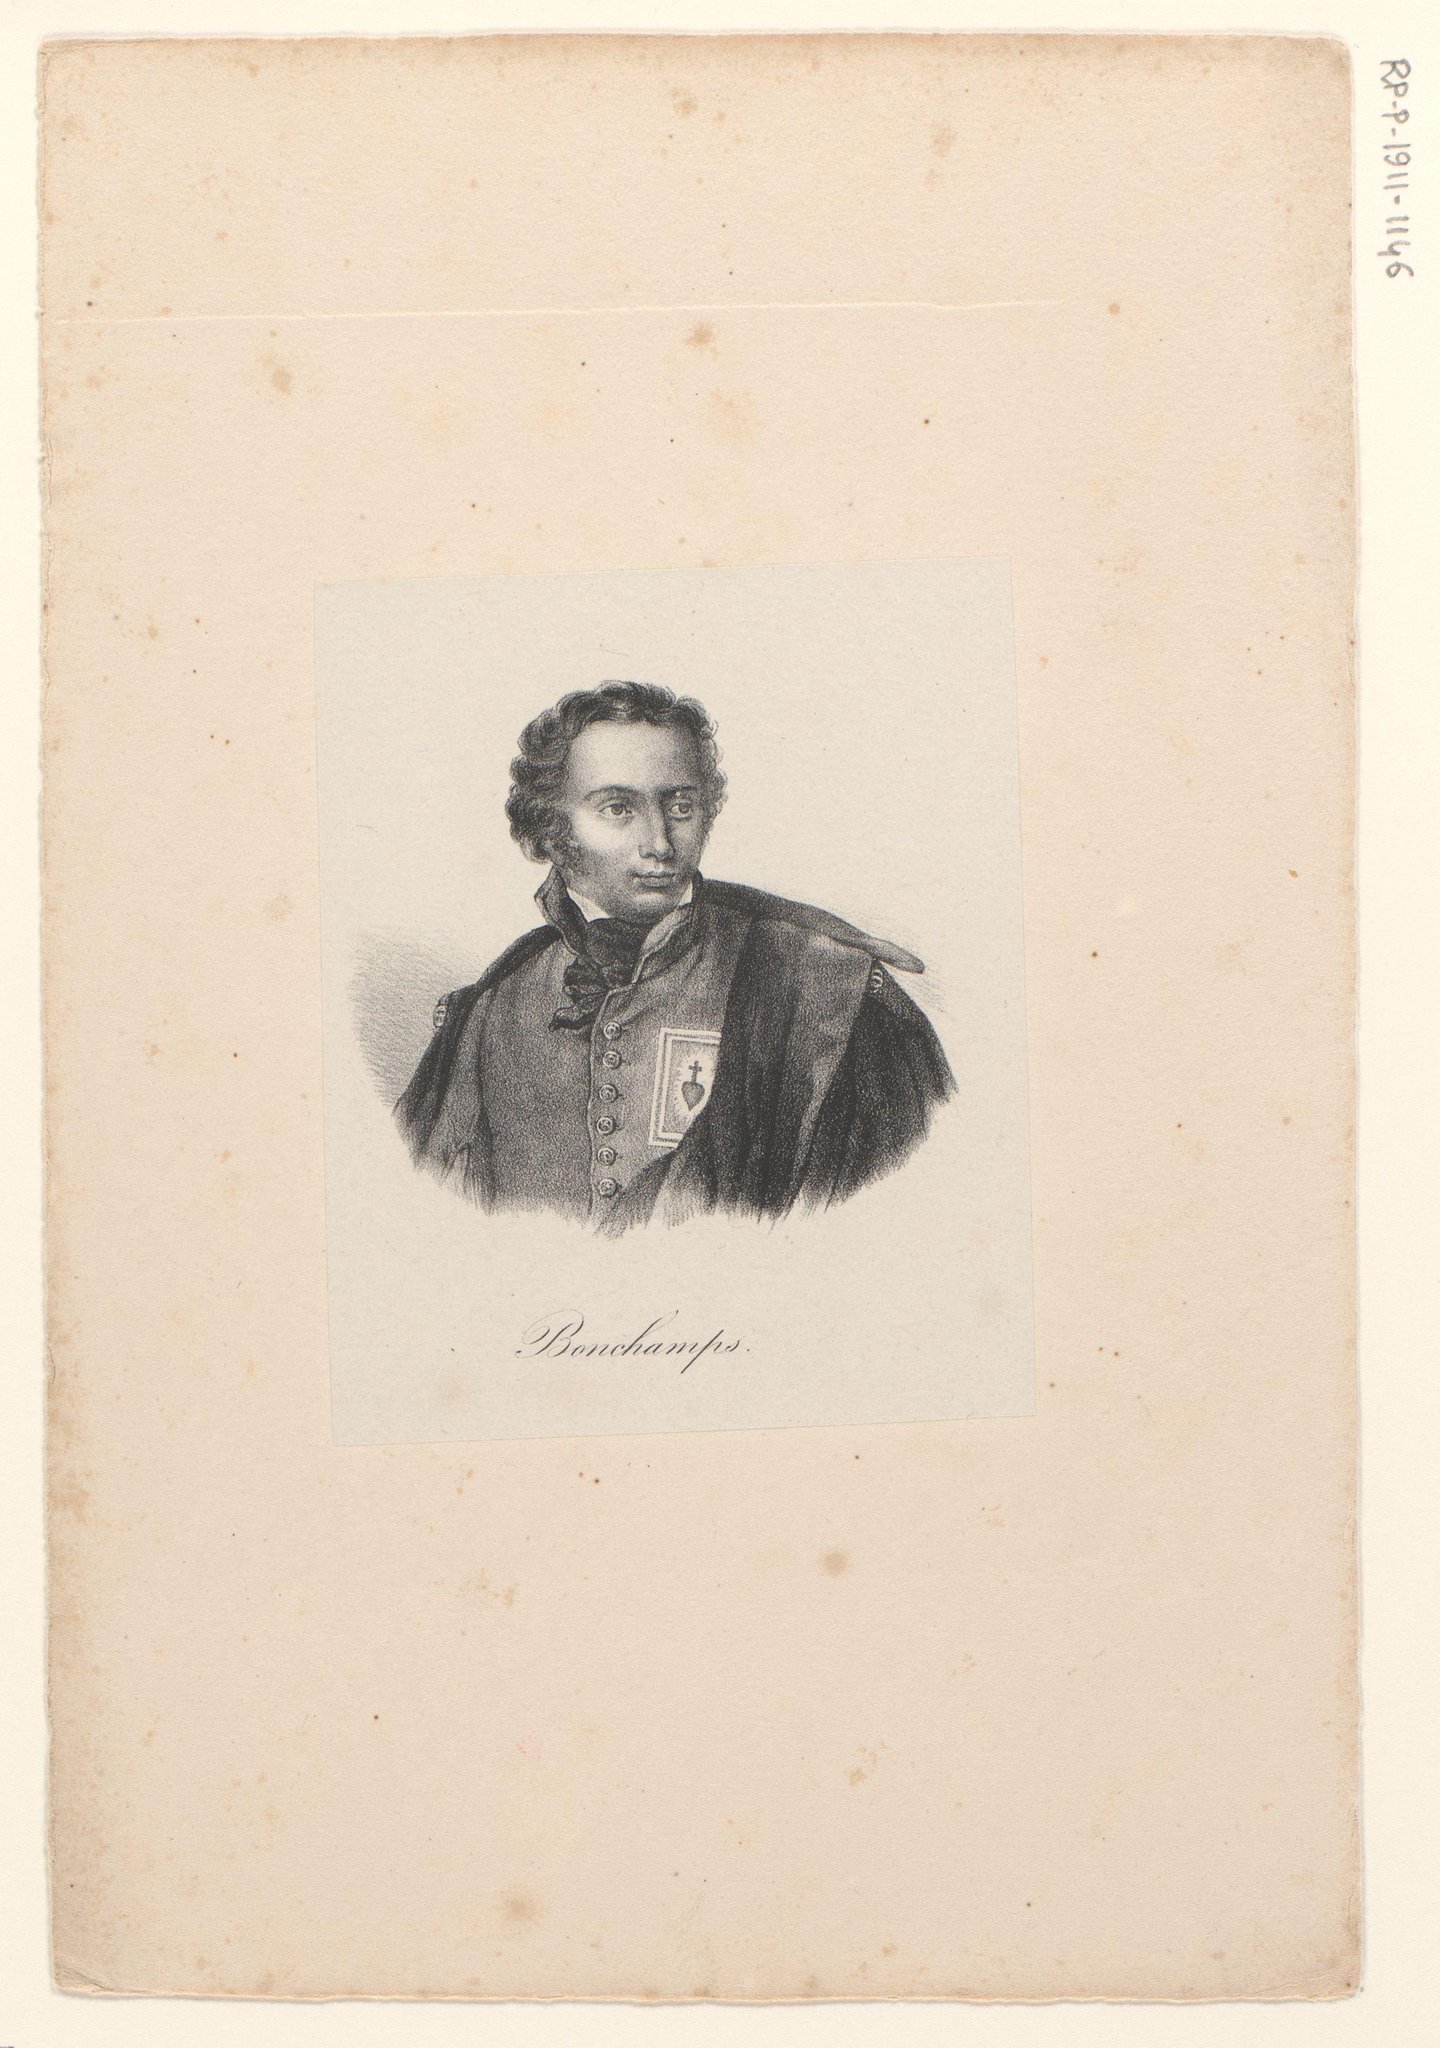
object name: print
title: Bonchamps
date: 1818-1842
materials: paper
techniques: lithograph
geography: paris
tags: politician, historical persons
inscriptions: collector's mark: Lugt 2228a